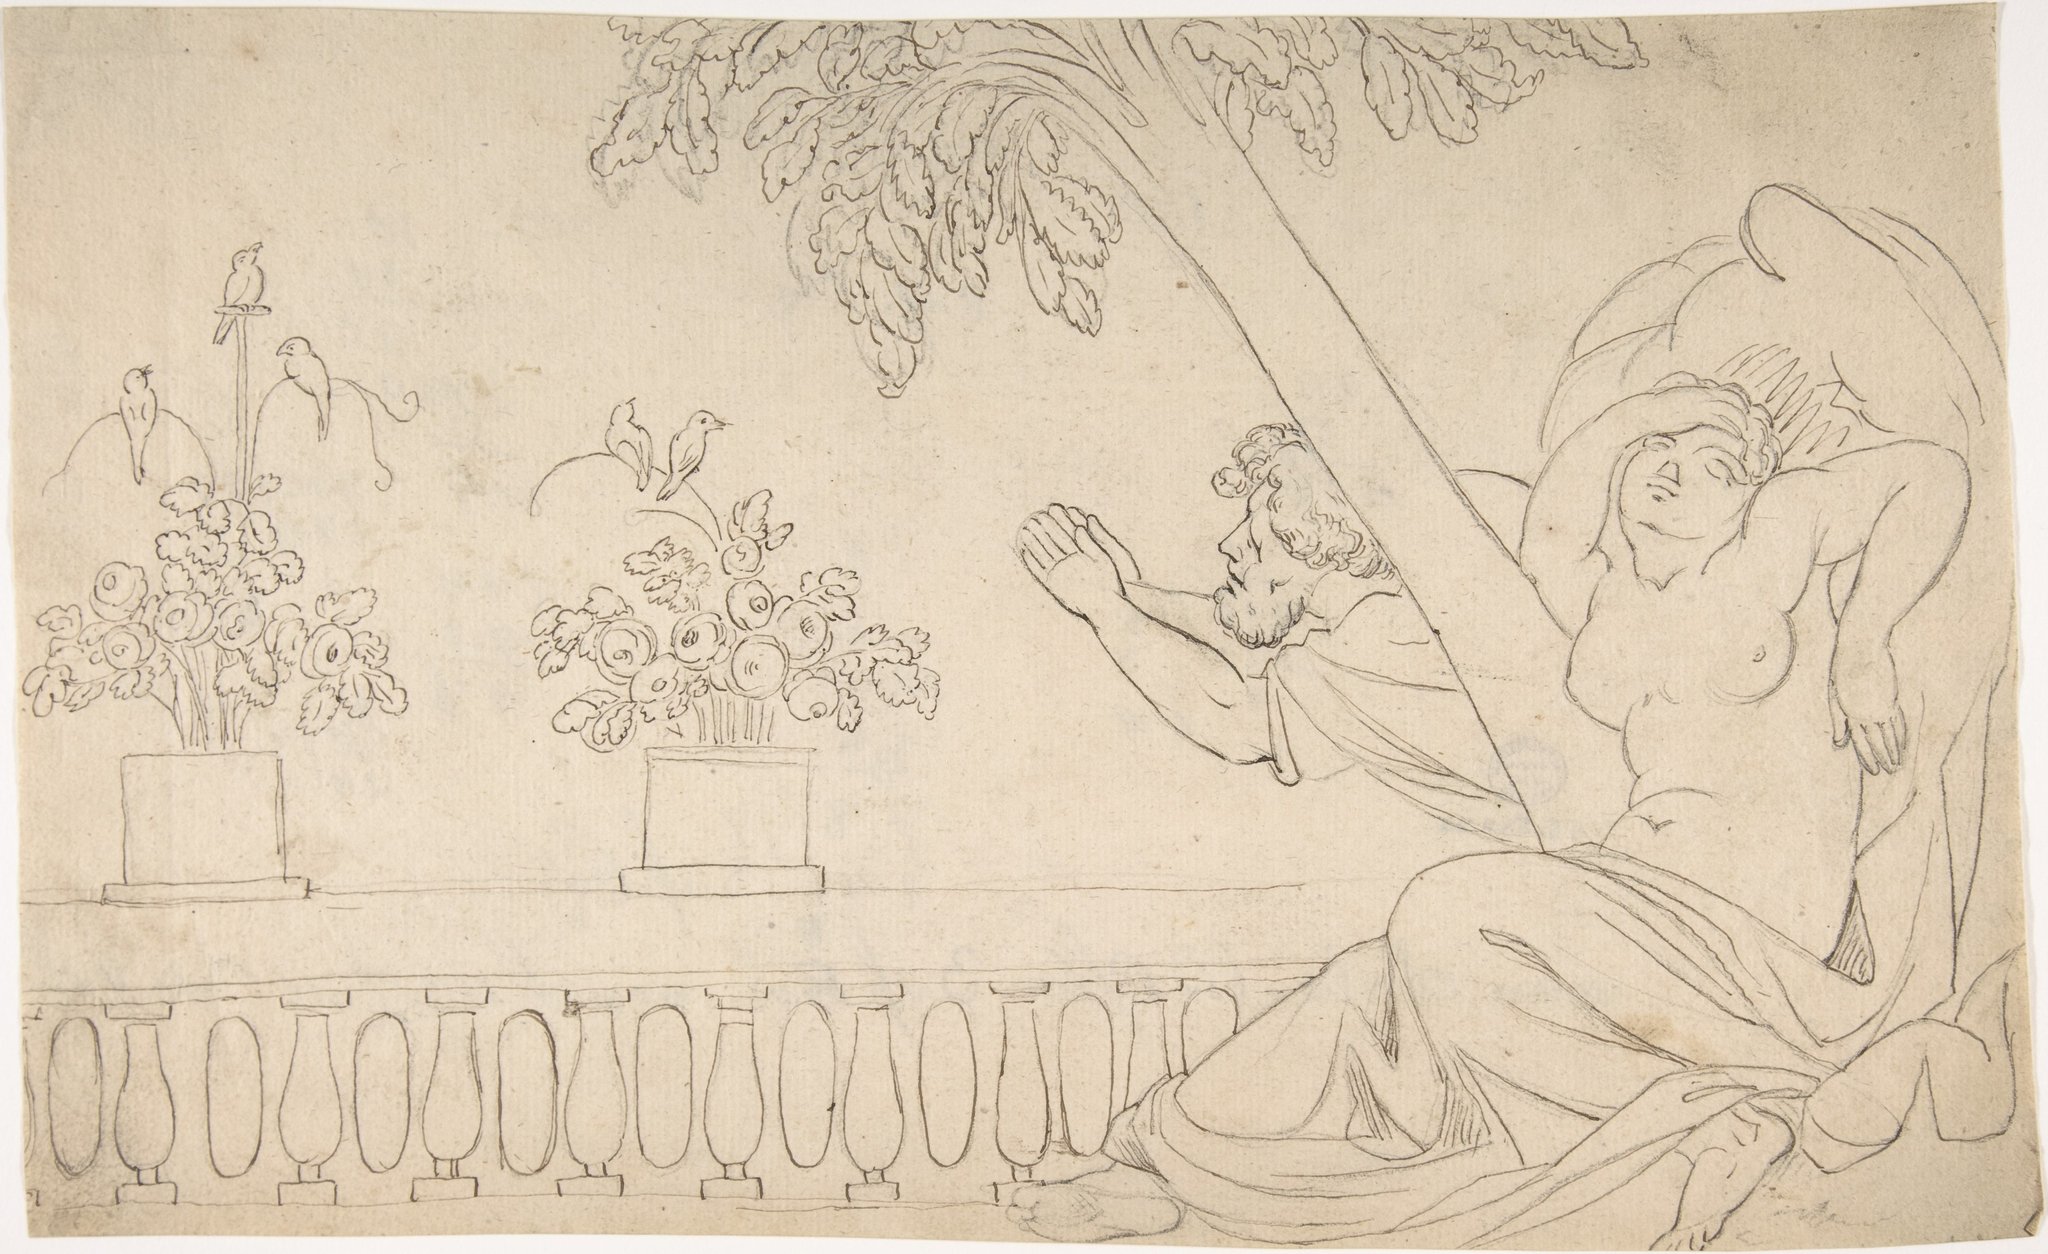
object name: drawing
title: Beseeching Couple under a Tree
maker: anonymous, german, 19th century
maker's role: artist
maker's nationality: german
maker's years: 1800-1899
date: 1780-1820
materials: graphite, ink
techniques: pen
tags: couples,men,female nudes,trees